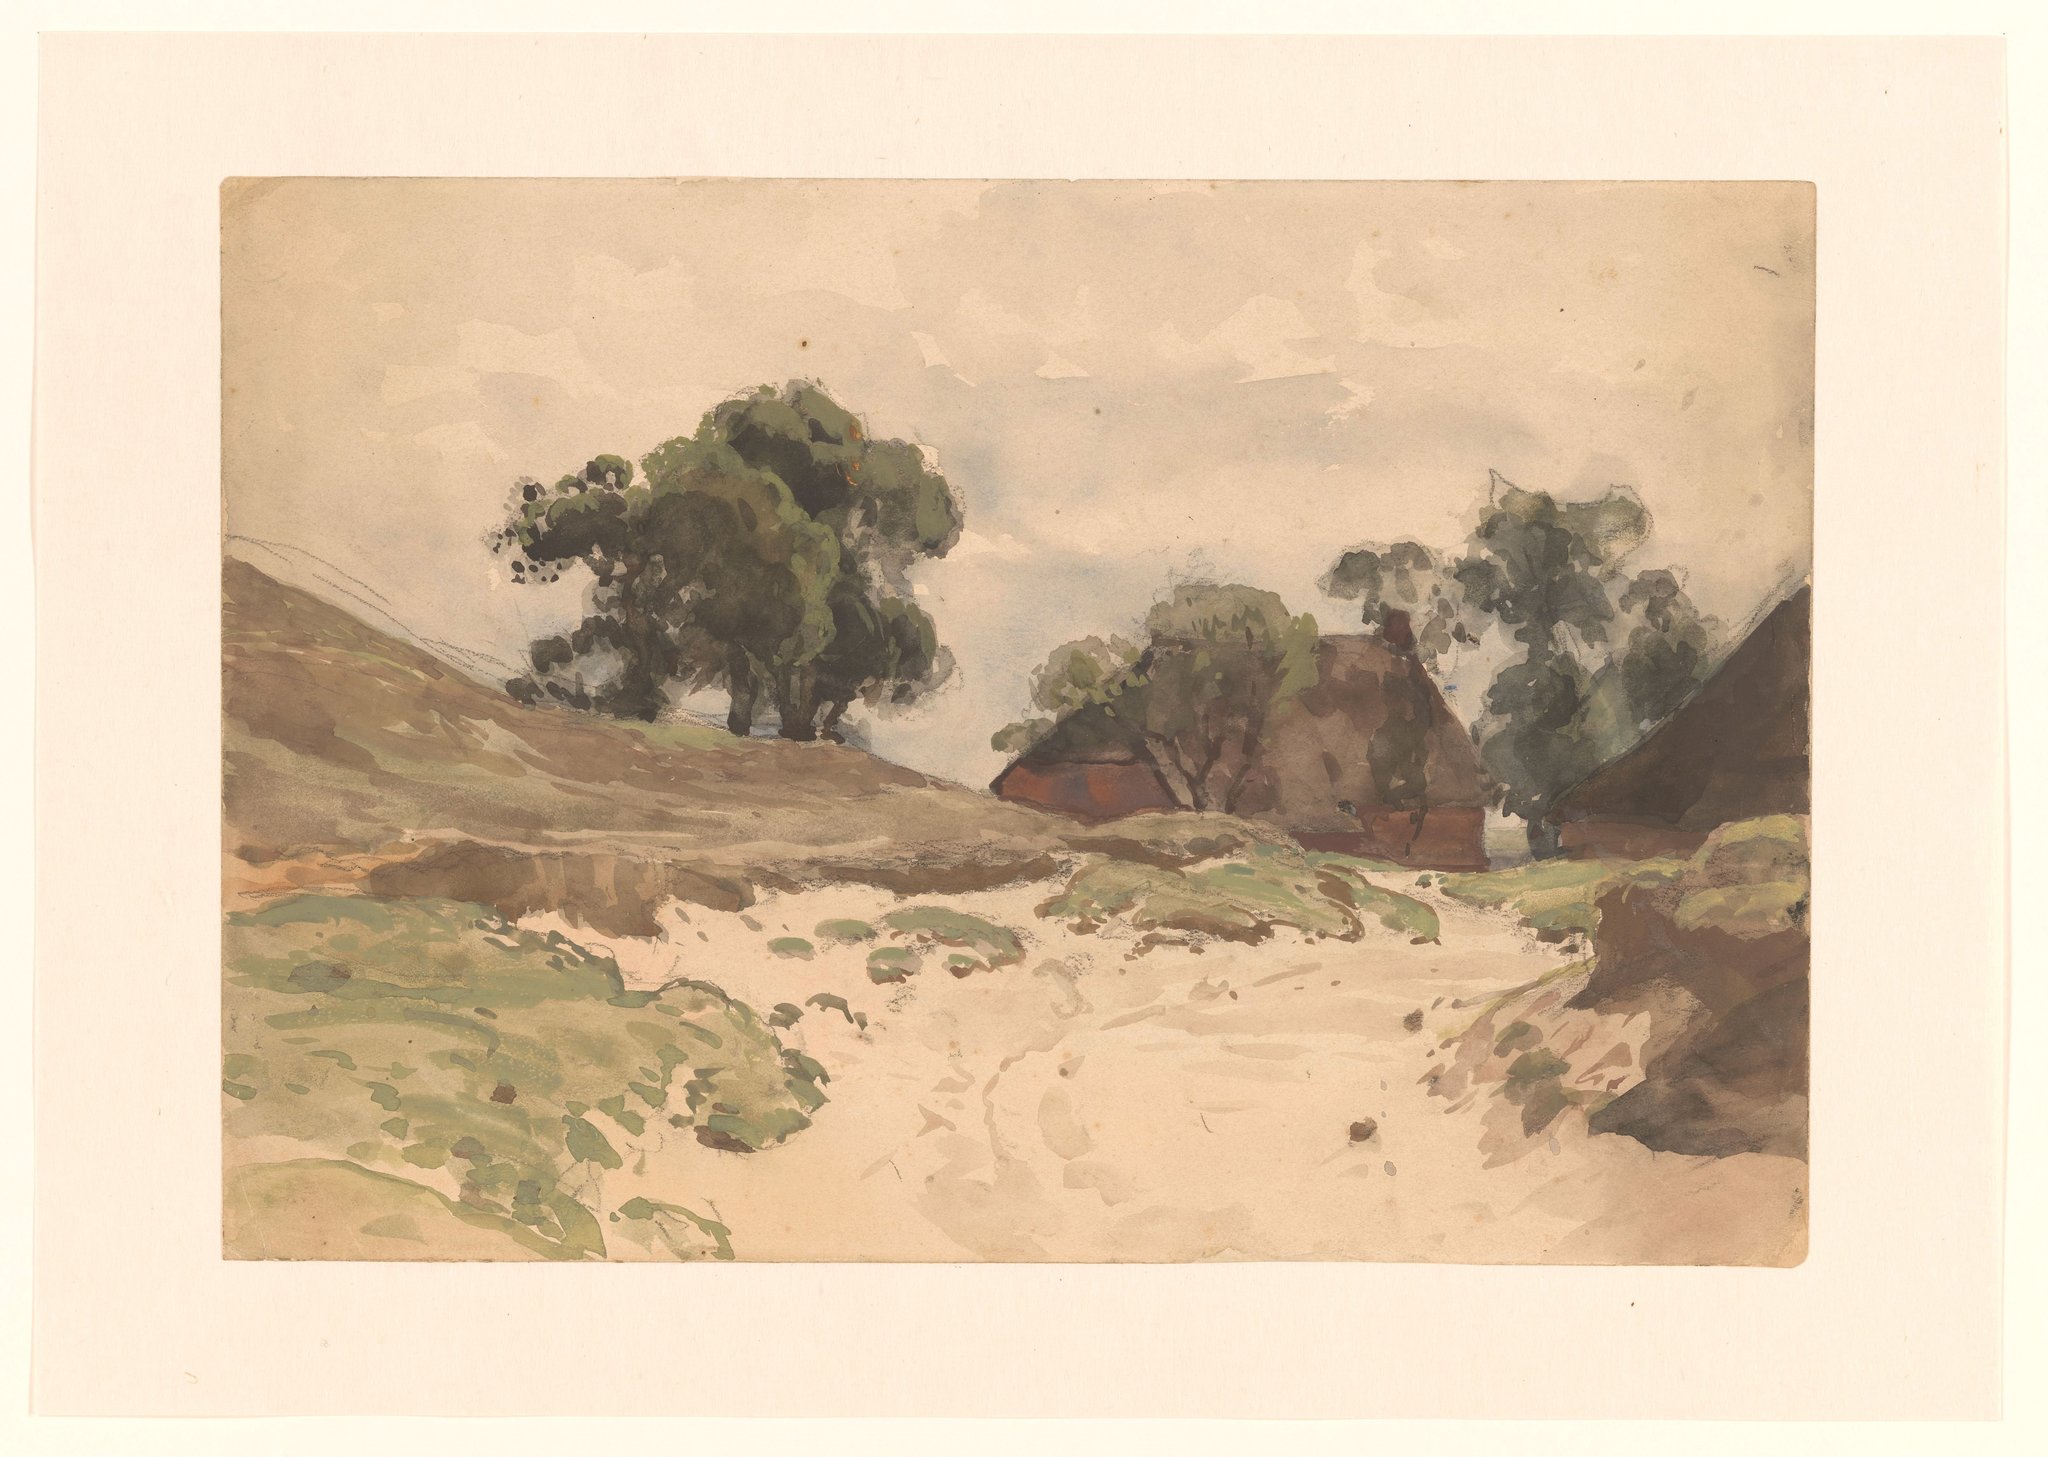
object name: watercolor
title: Landschap met boerderij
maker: julius jacobus van de sande bakhuyzen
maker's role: draughtsman, painter, print maker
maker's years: 1835-1925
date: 1845-1925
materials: chalk, paper, watercolor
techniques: brush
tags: farm or solitary house in landscape